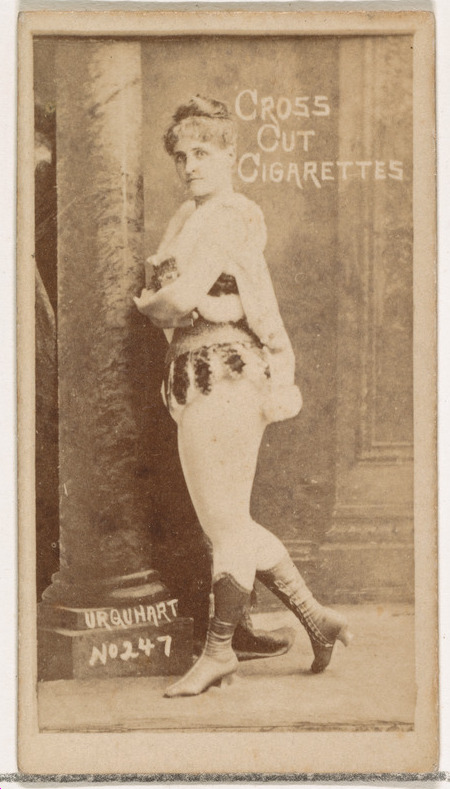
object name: print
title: Card Number 247, Urquhart, from the Actors and Actresses series (N145-1) issued by Duke Sons & Co. to promote Cross Cut Cigarettes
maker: w. duke, sons & co.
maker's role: publisher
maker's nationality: american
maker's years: 1870-1920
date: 1880-1889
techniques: albumen silver print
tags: portraits,women,actresses